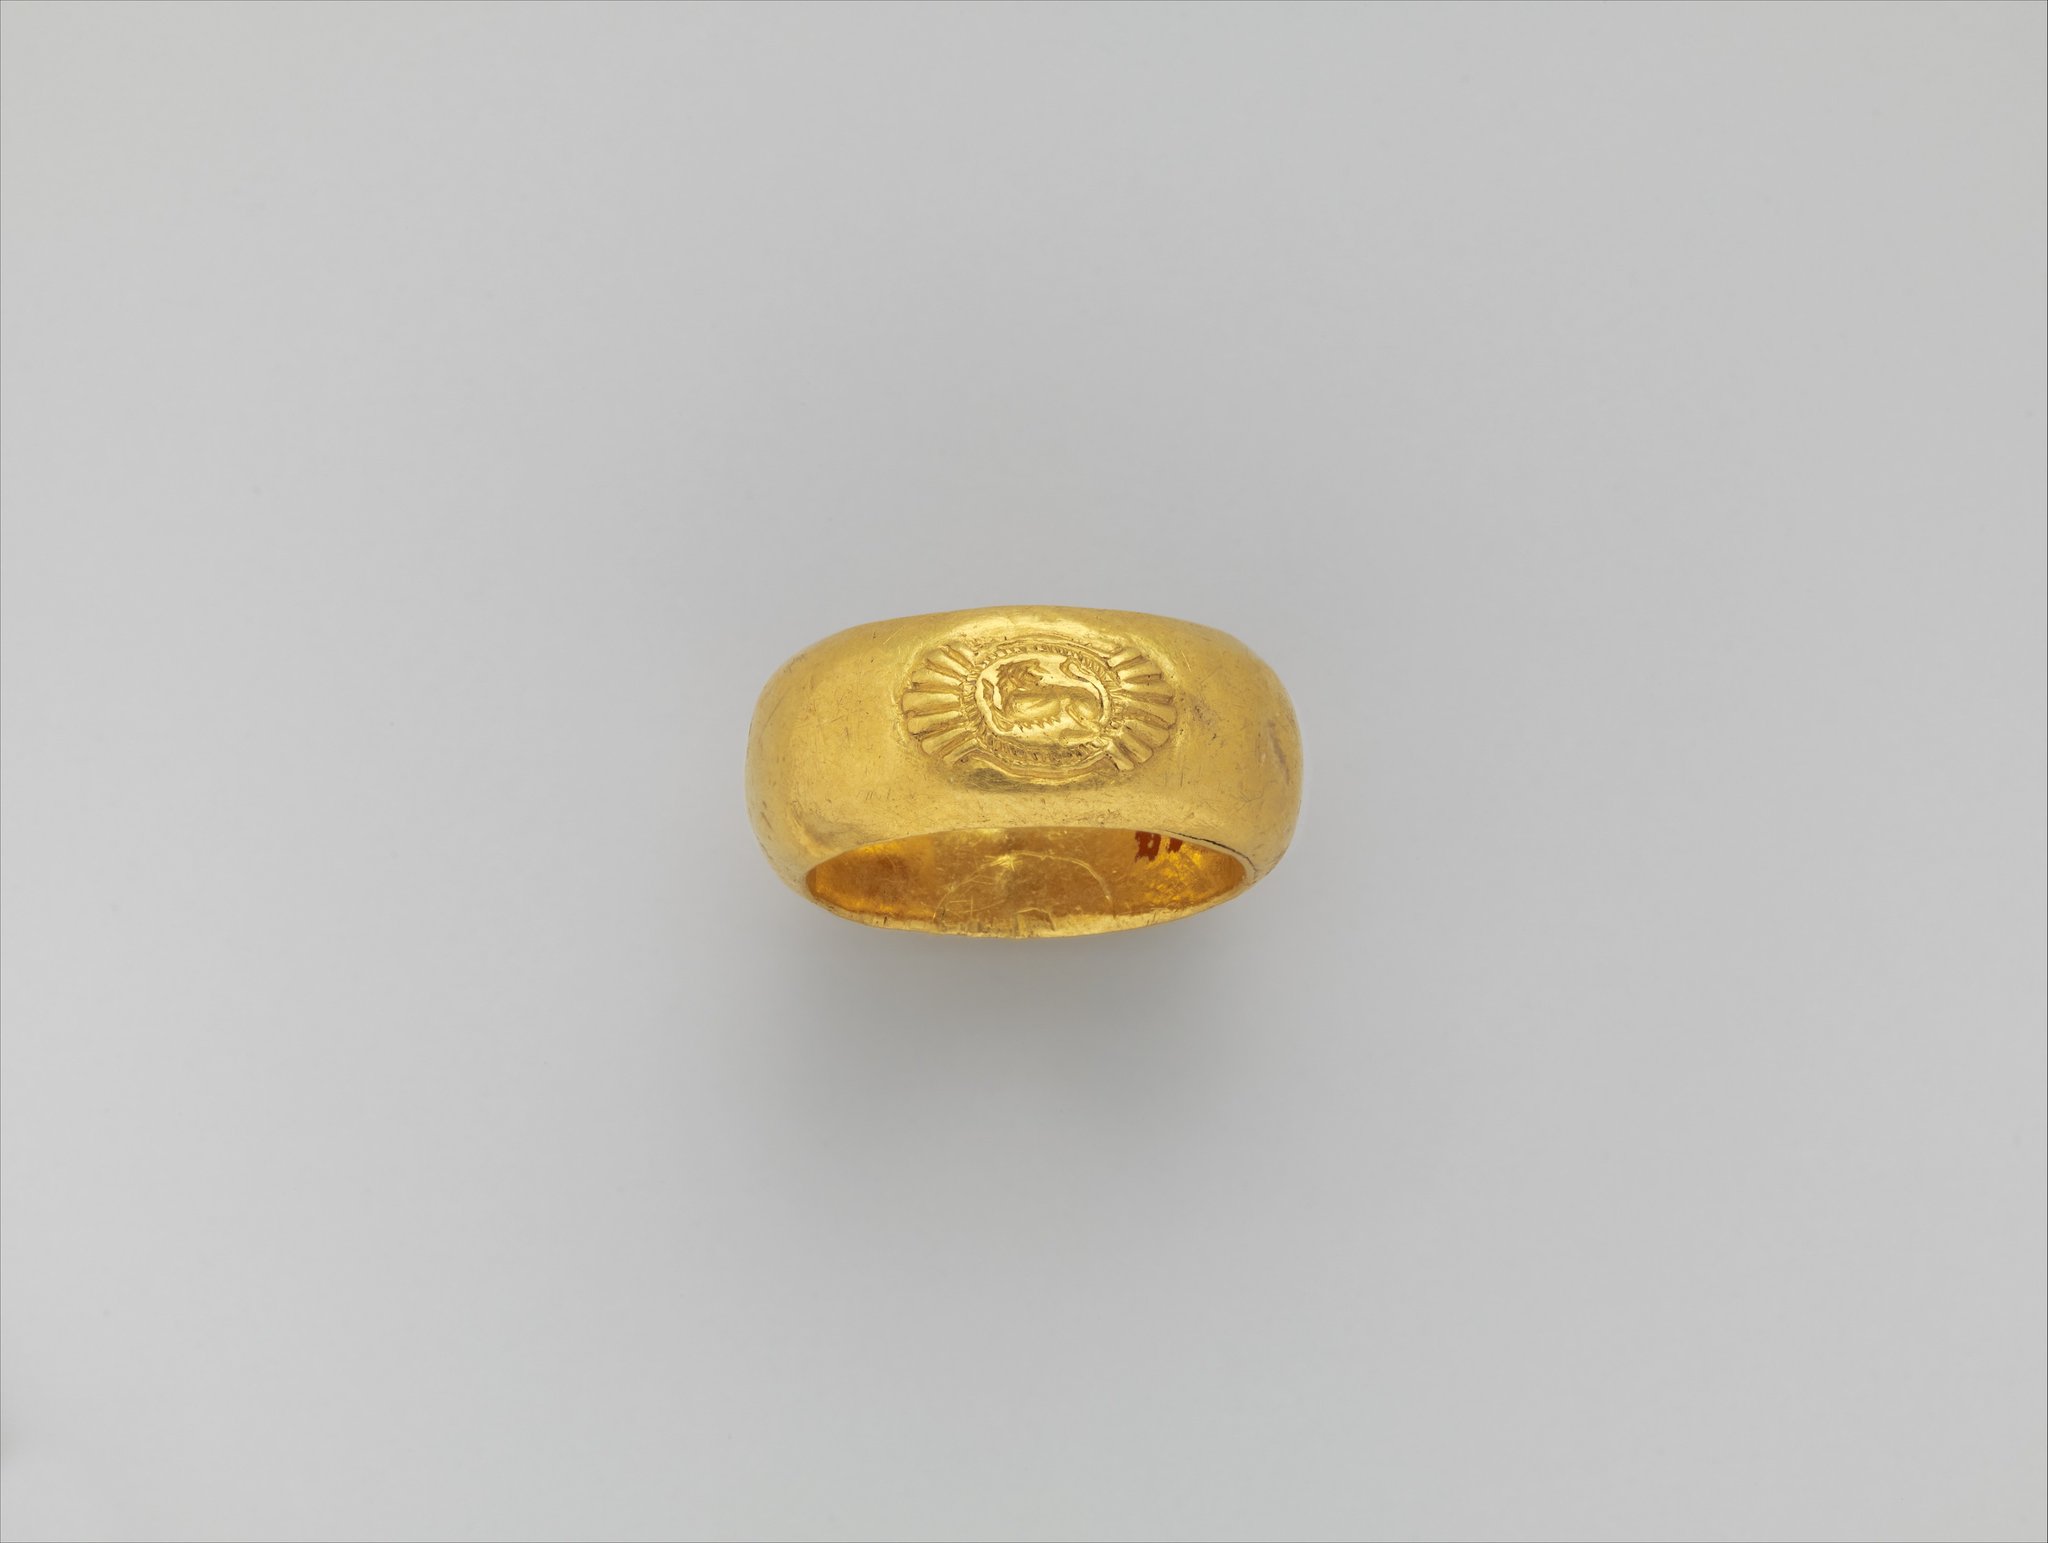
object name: ring with intaglio of lion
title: Gold ring: on bezel, lion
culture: etruscan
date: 500-468 BCE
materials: gold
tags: lions